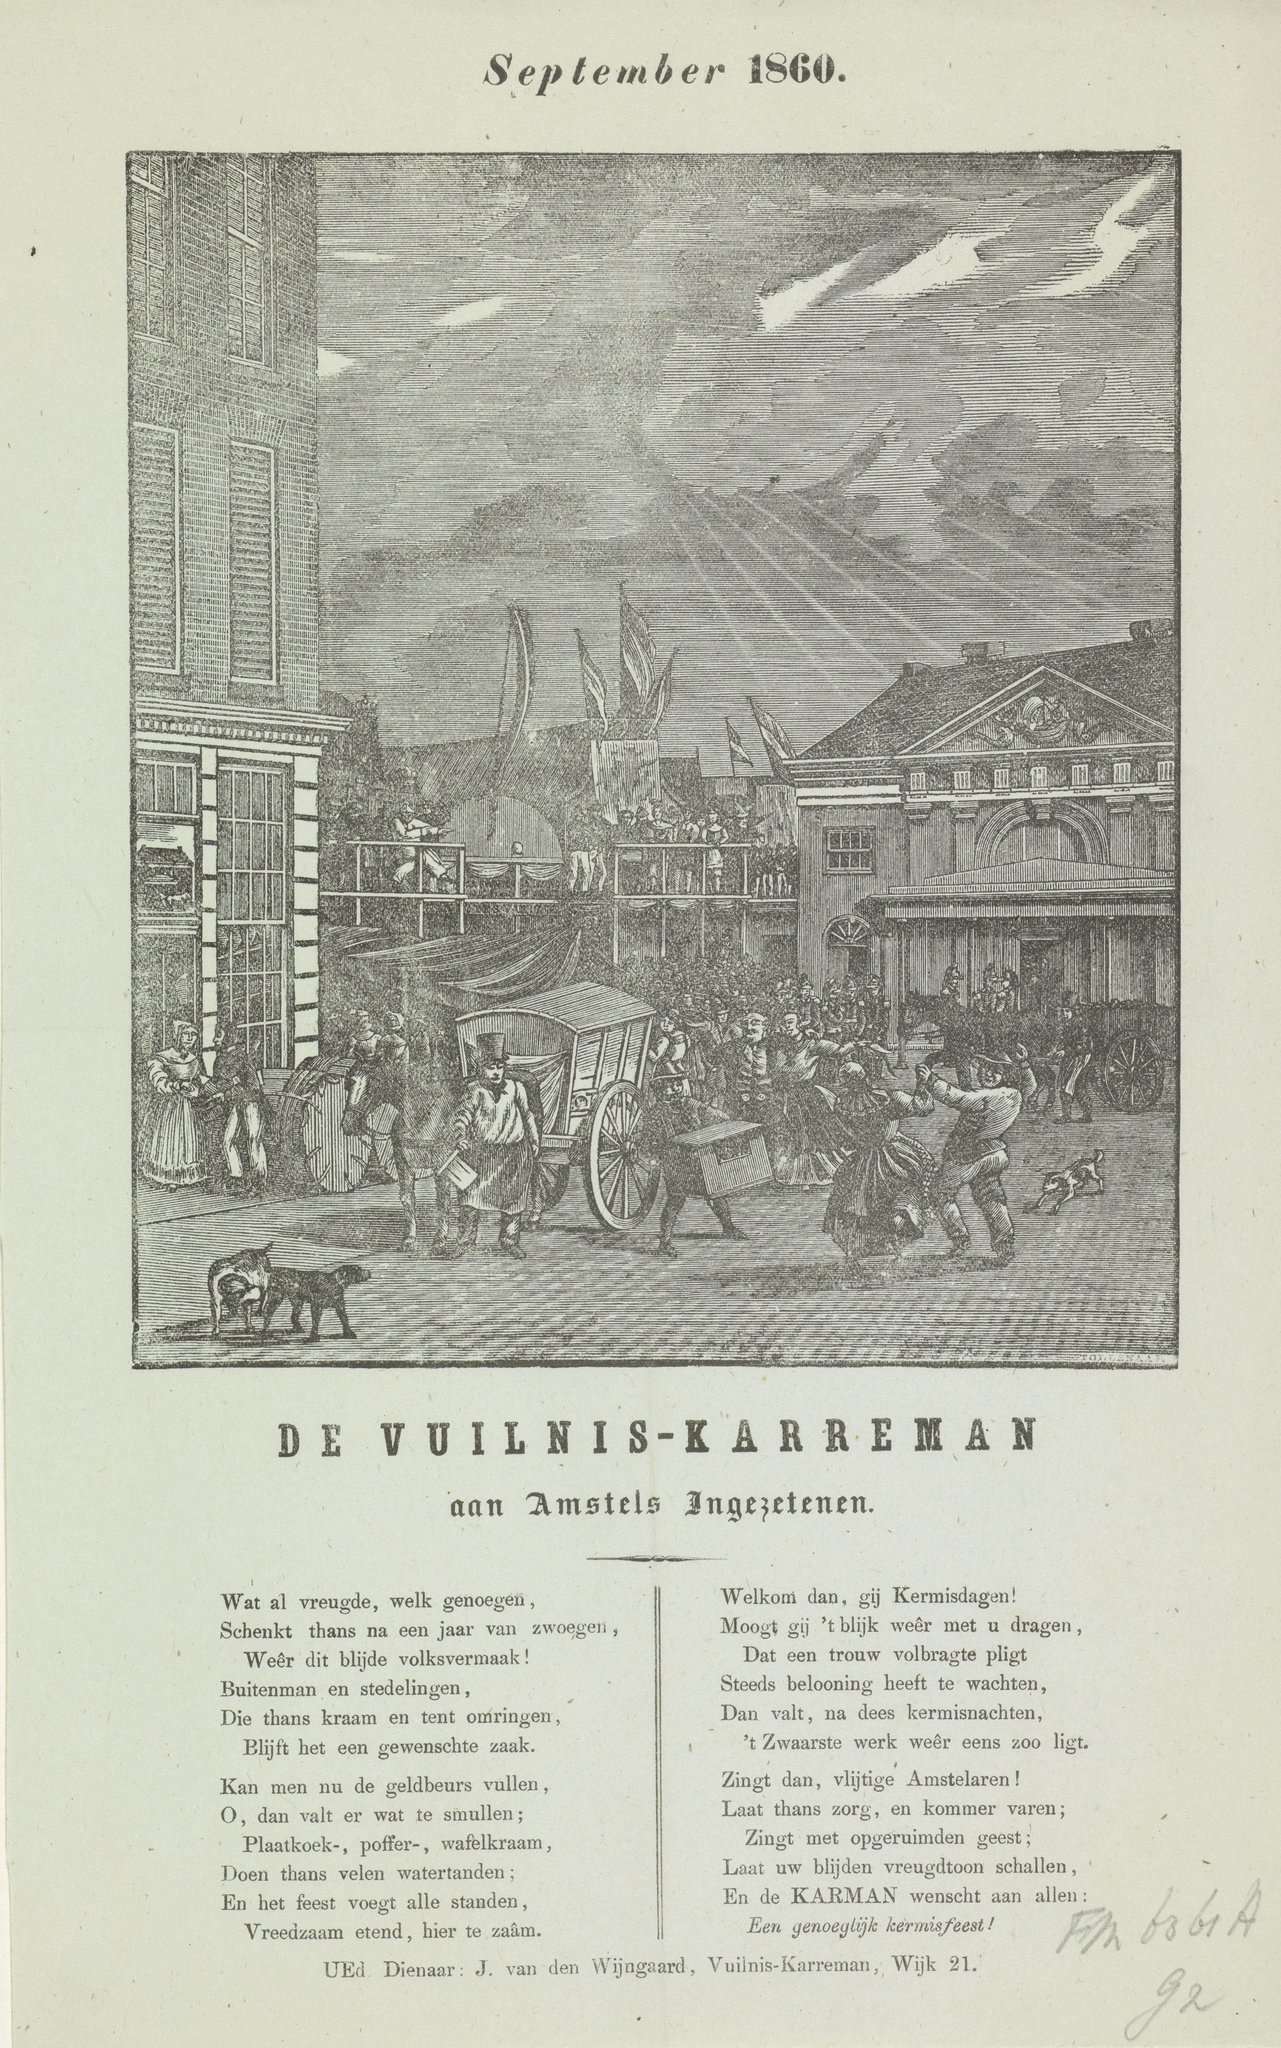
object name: print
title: De Vuilnis-karreman aan Amstels Ingezetenen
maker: dirk wijbrand tollenaar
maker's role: print maker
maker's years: 1808-1858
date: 1860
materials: paper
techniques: letterpress printing, engraving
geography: amsterdam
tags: street, garbage collection, amsterdam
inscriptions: collector's mark: Lugt 2228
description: Kermisprent van de Amsterdamse vuilnismannen voor het jaar 1860. Gezicht op de kermis op de Botermarkt met de oude Waag. Op de markt twee vuilniskarren. Met gedicht in twee kolommen. Van de vuilniskarman in de wijk no. 21: J. van den Wijngaard.